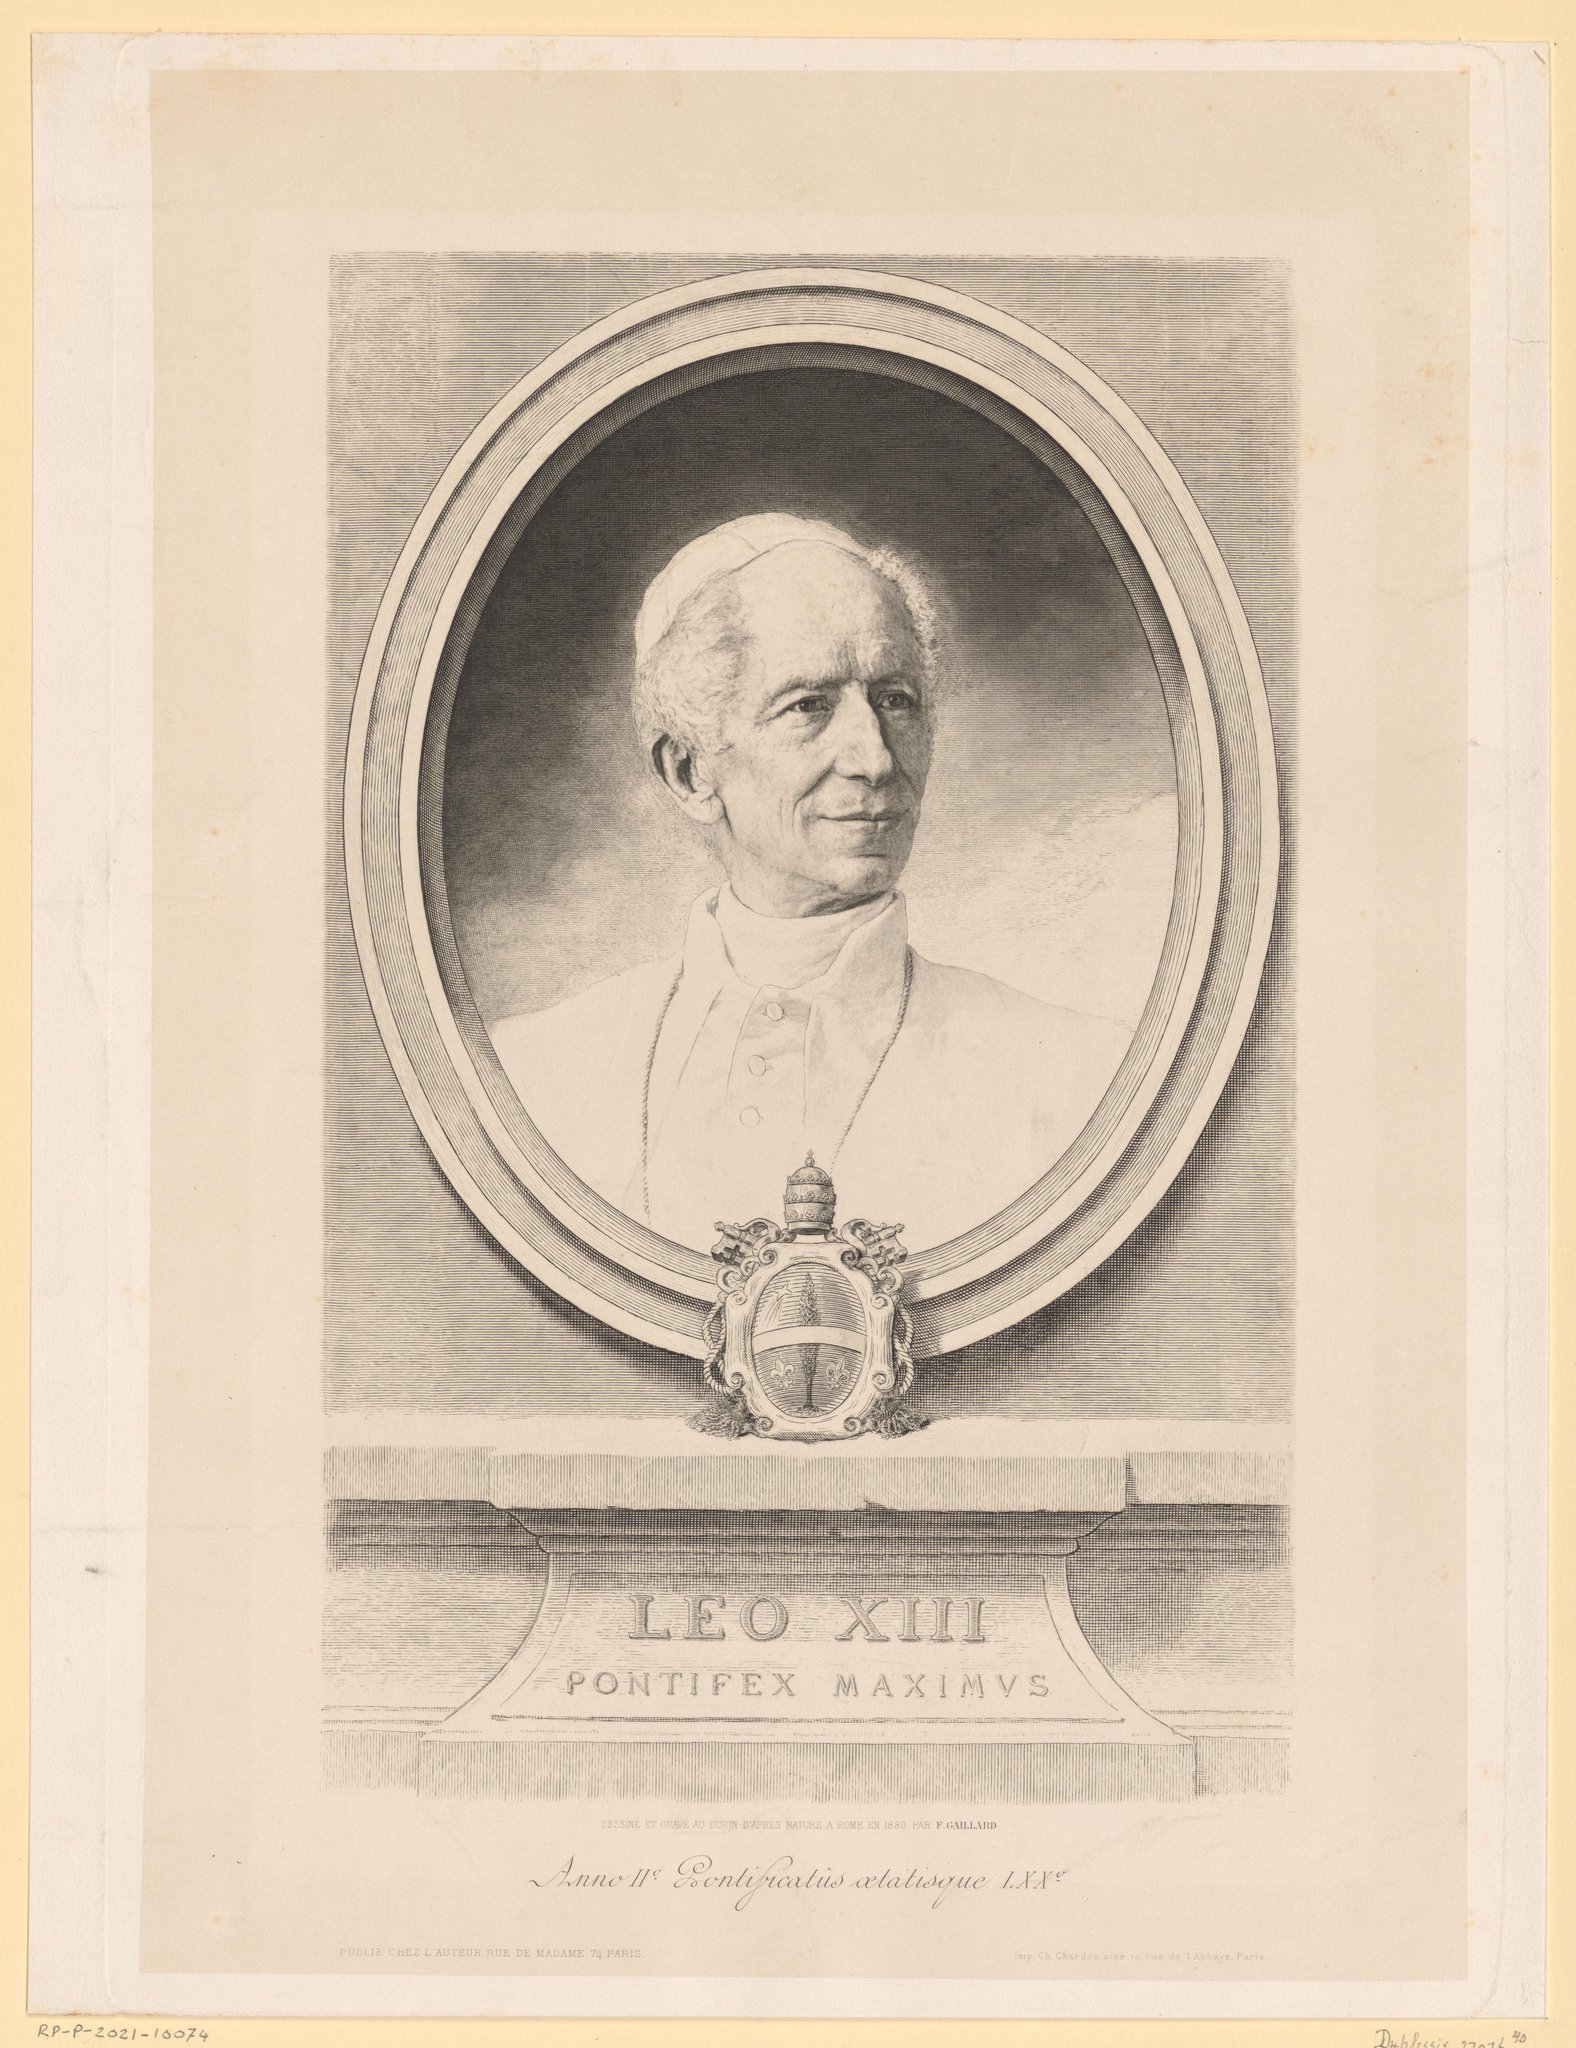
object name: print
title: Portret van Leo XIII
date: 1880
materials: paper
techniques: engraving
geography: rome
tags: leo xiii, historical persons, pope, armorial bearing, heraldry